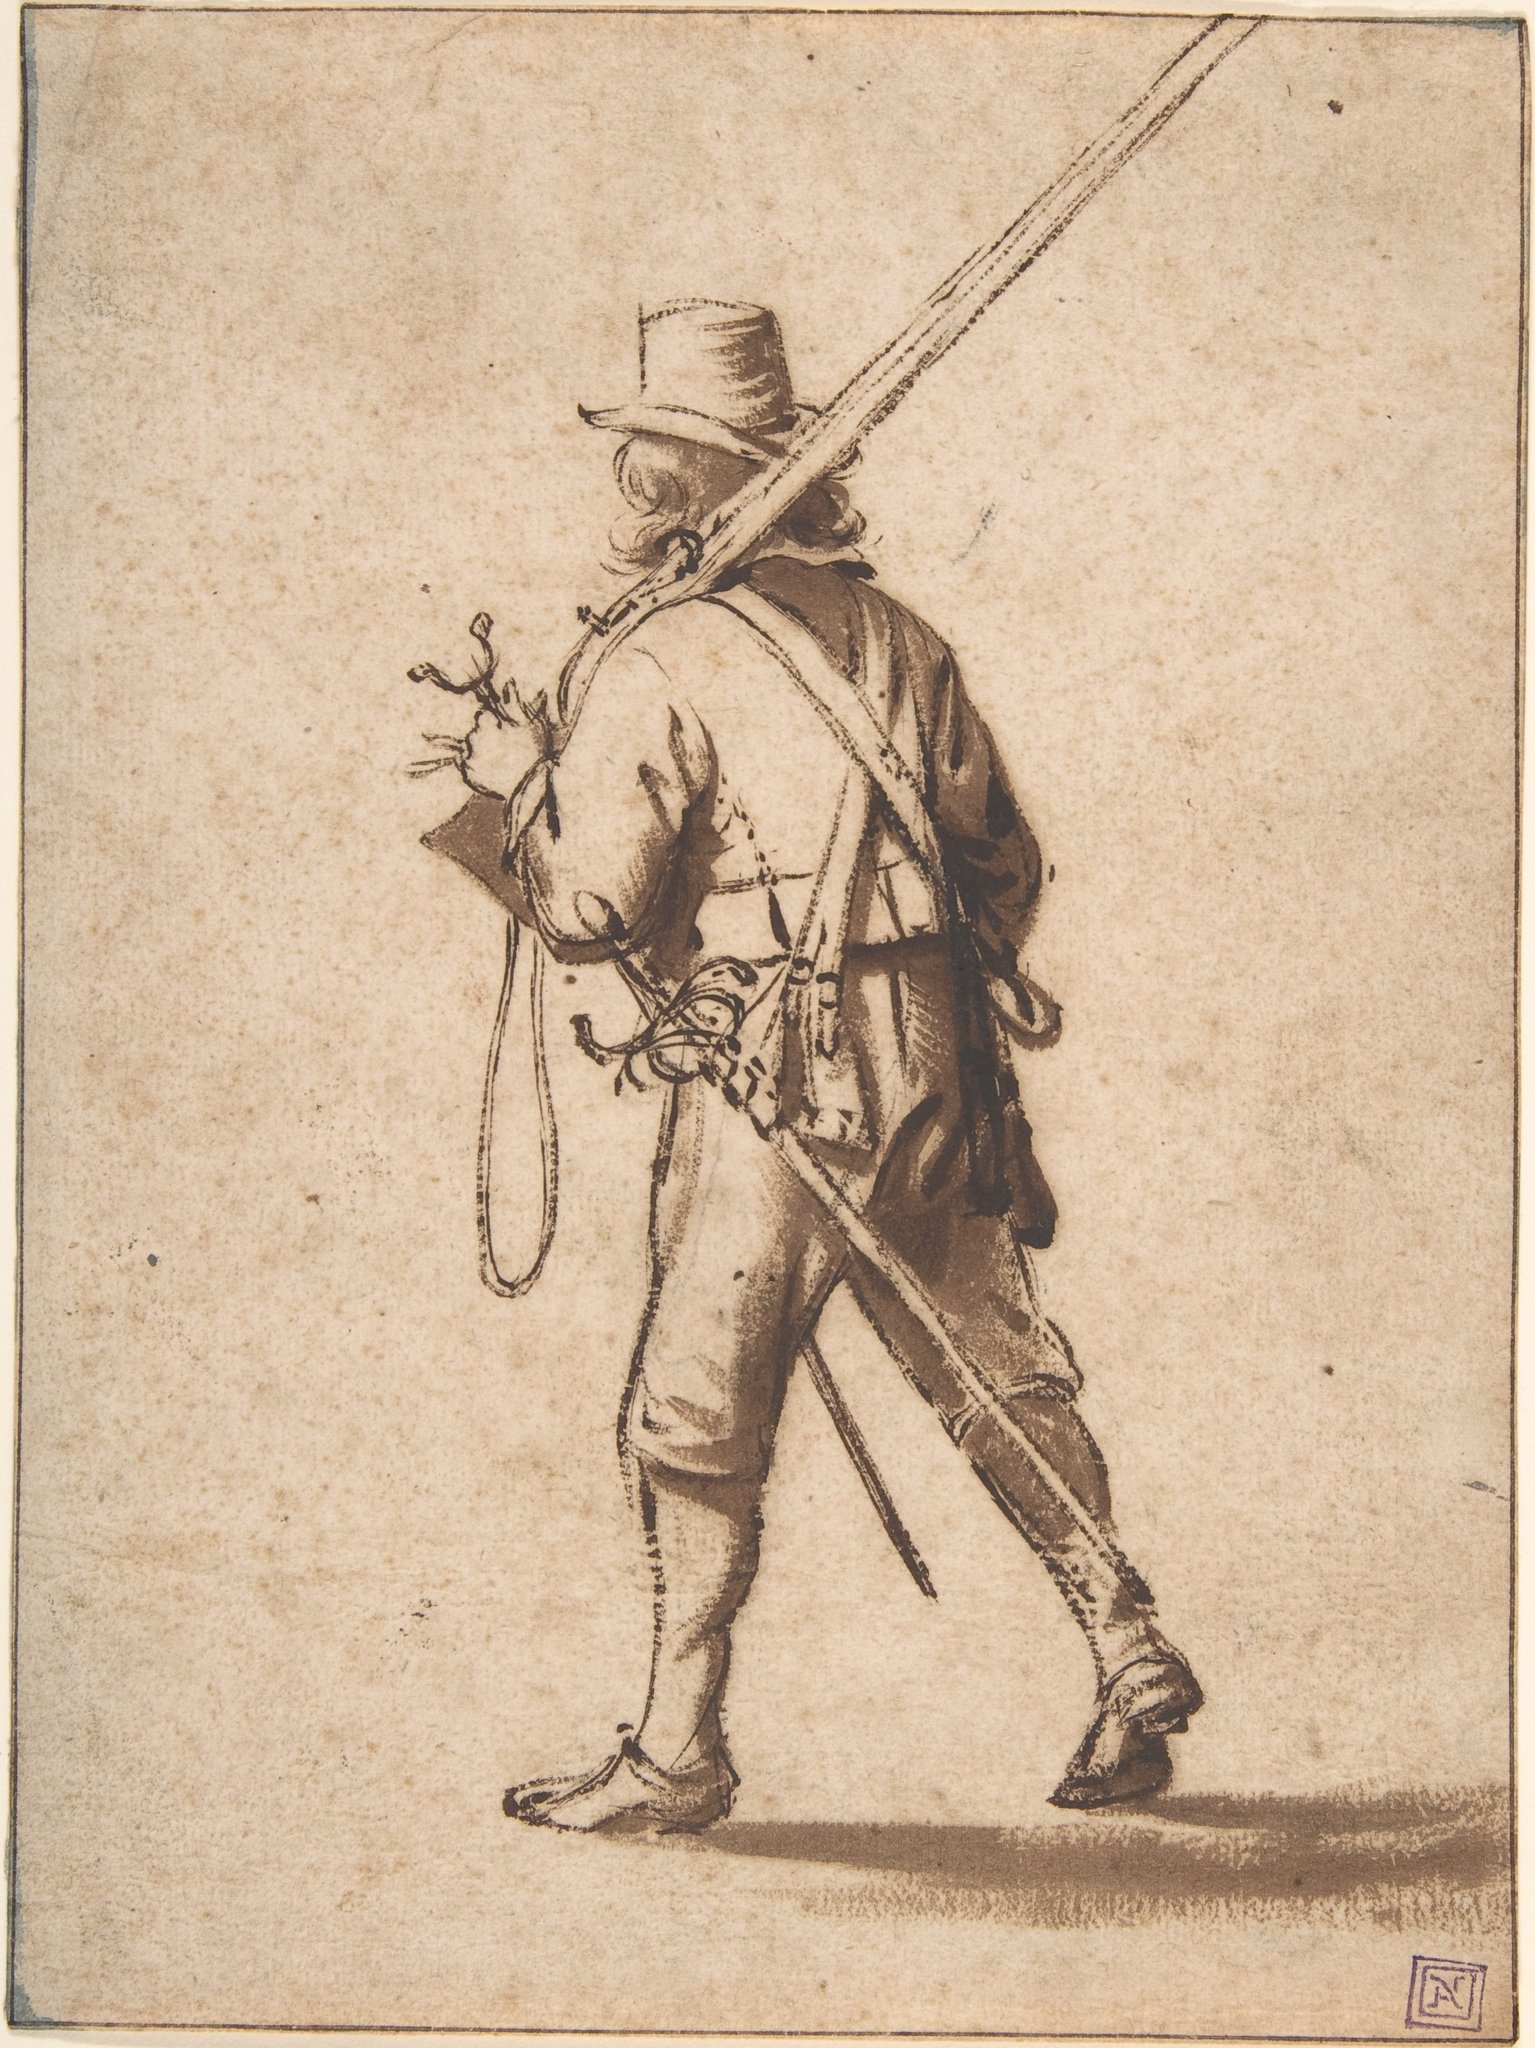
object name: drawing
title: A Walking Musketeer, seen from behind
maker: anthonie palamedesz.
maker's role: artist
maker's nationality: dutch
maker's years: 1601-1673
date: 1601-1700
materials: chalk, ink, watercolor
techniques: brush, pen, wash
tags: soldiers,swords,men,walking